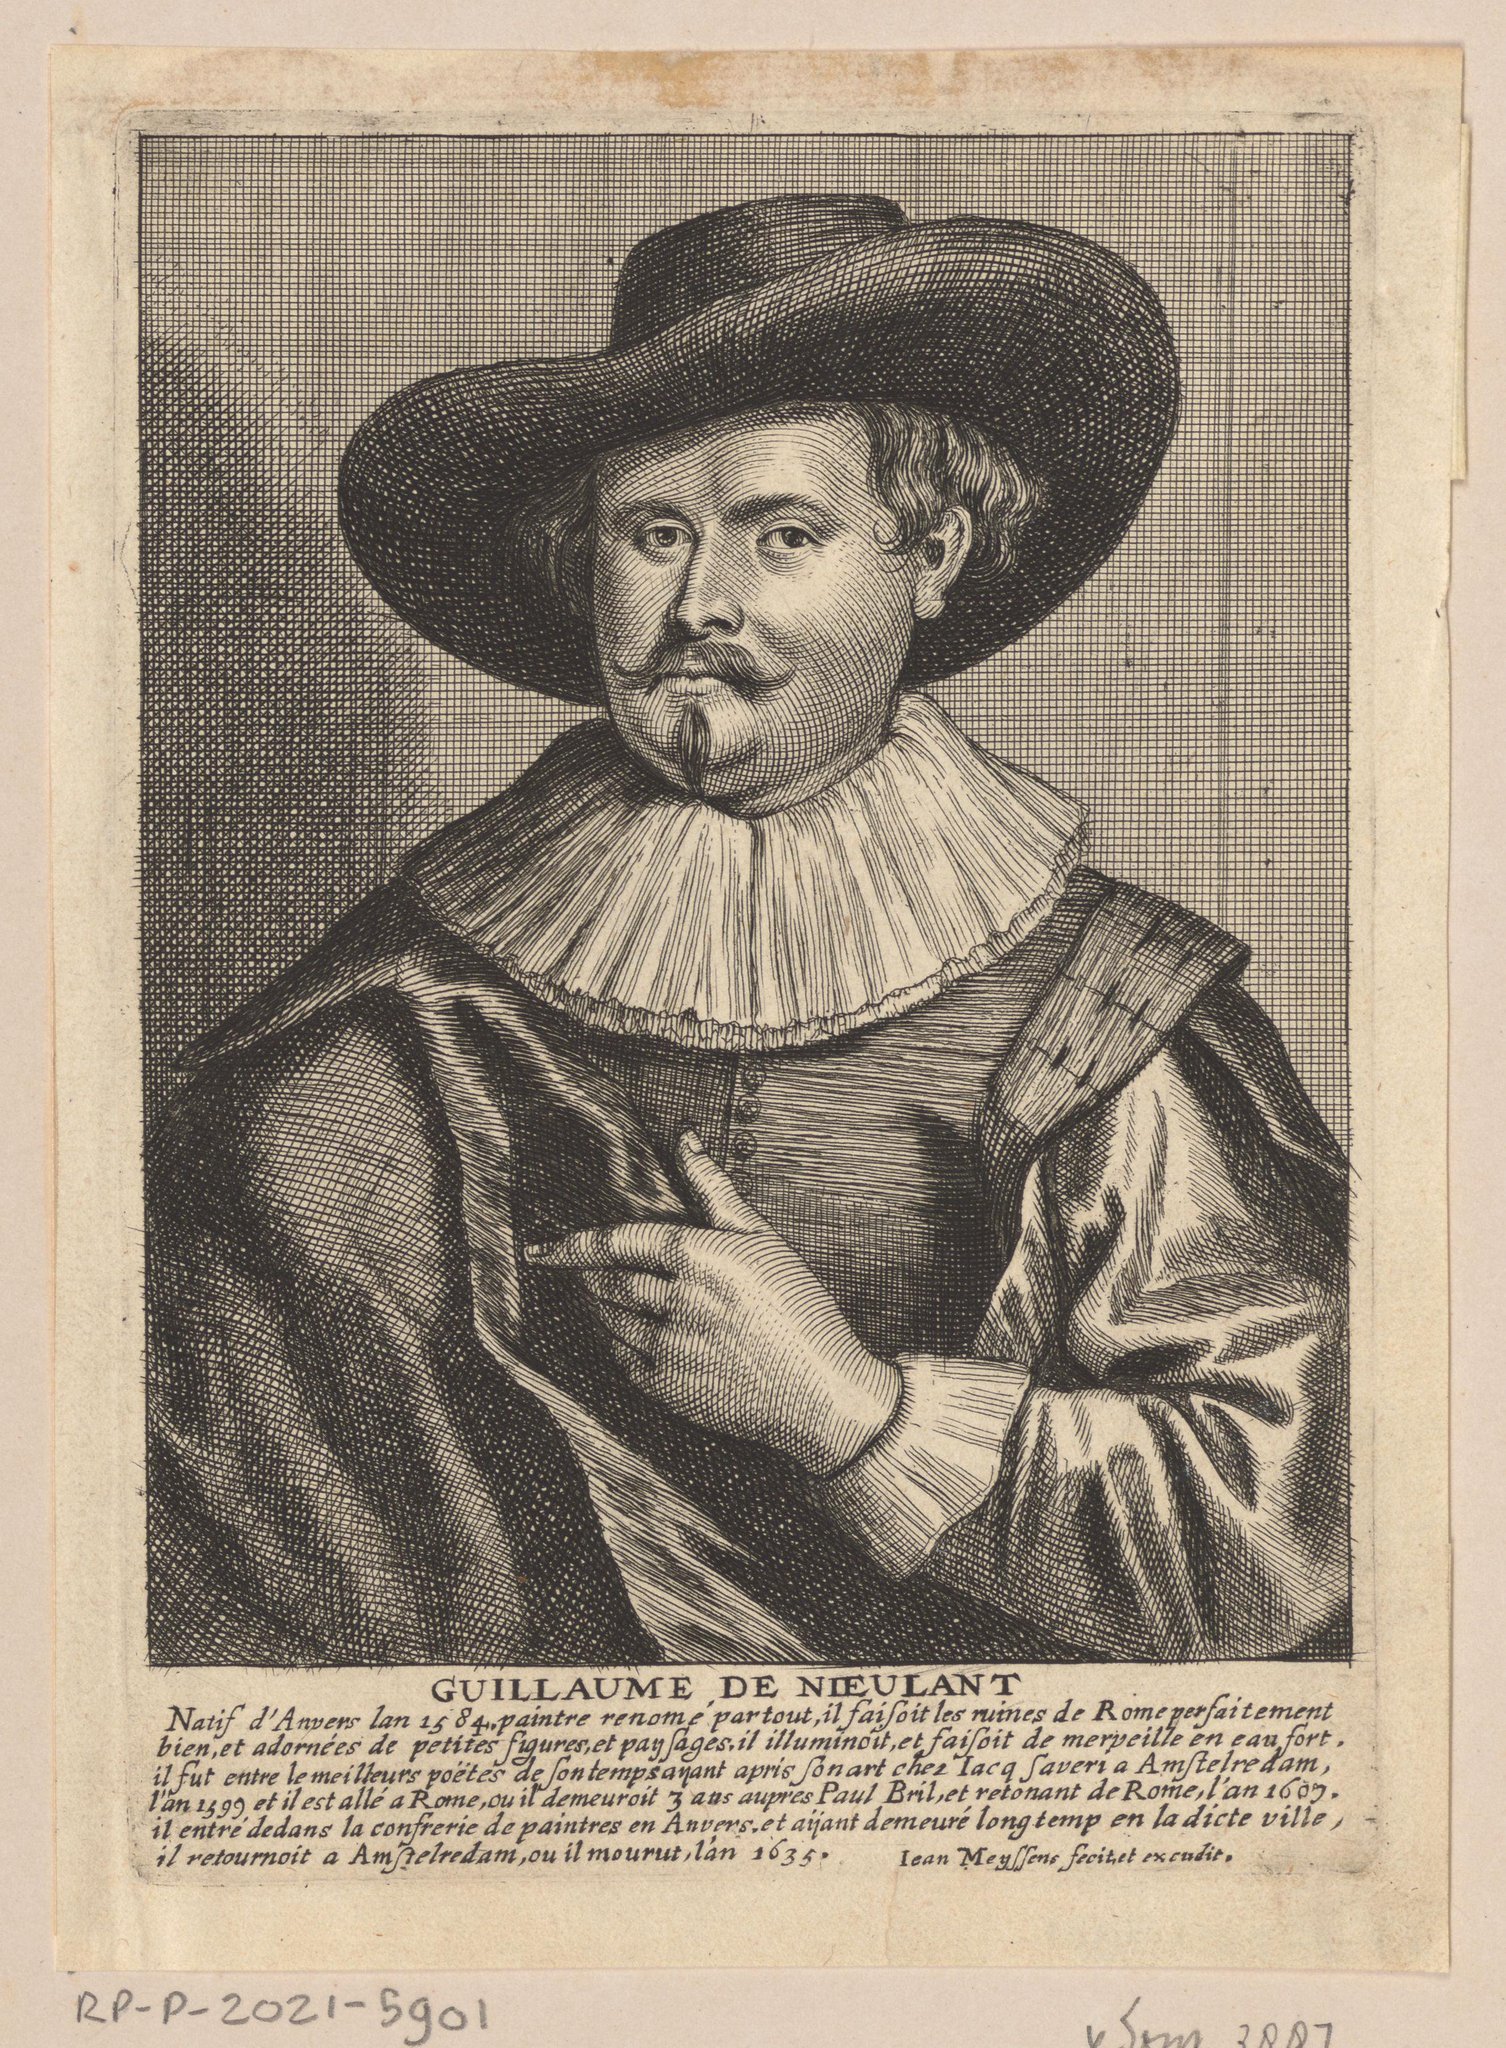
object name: print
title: Portret van Willem van Nieulandt II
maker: joannes meyssens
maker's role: print maker, publisher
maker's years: 1612-1670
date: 1662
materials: paper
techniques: engraving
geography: antwerp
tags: antwerp, amsterdam, print maker, draughtsman, guilliam van nieulandt (ii), historical persons, portrait, self-portrait of artist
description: Prent waarschijnlijk uit: Bie, Cornelis de. Het gulden cabinet vande edele vry schilder-const. 3 dln. Antwerpen: Joannes Meyssens en Juliaen van Montfort, 1662, dl. 1, p. 63.